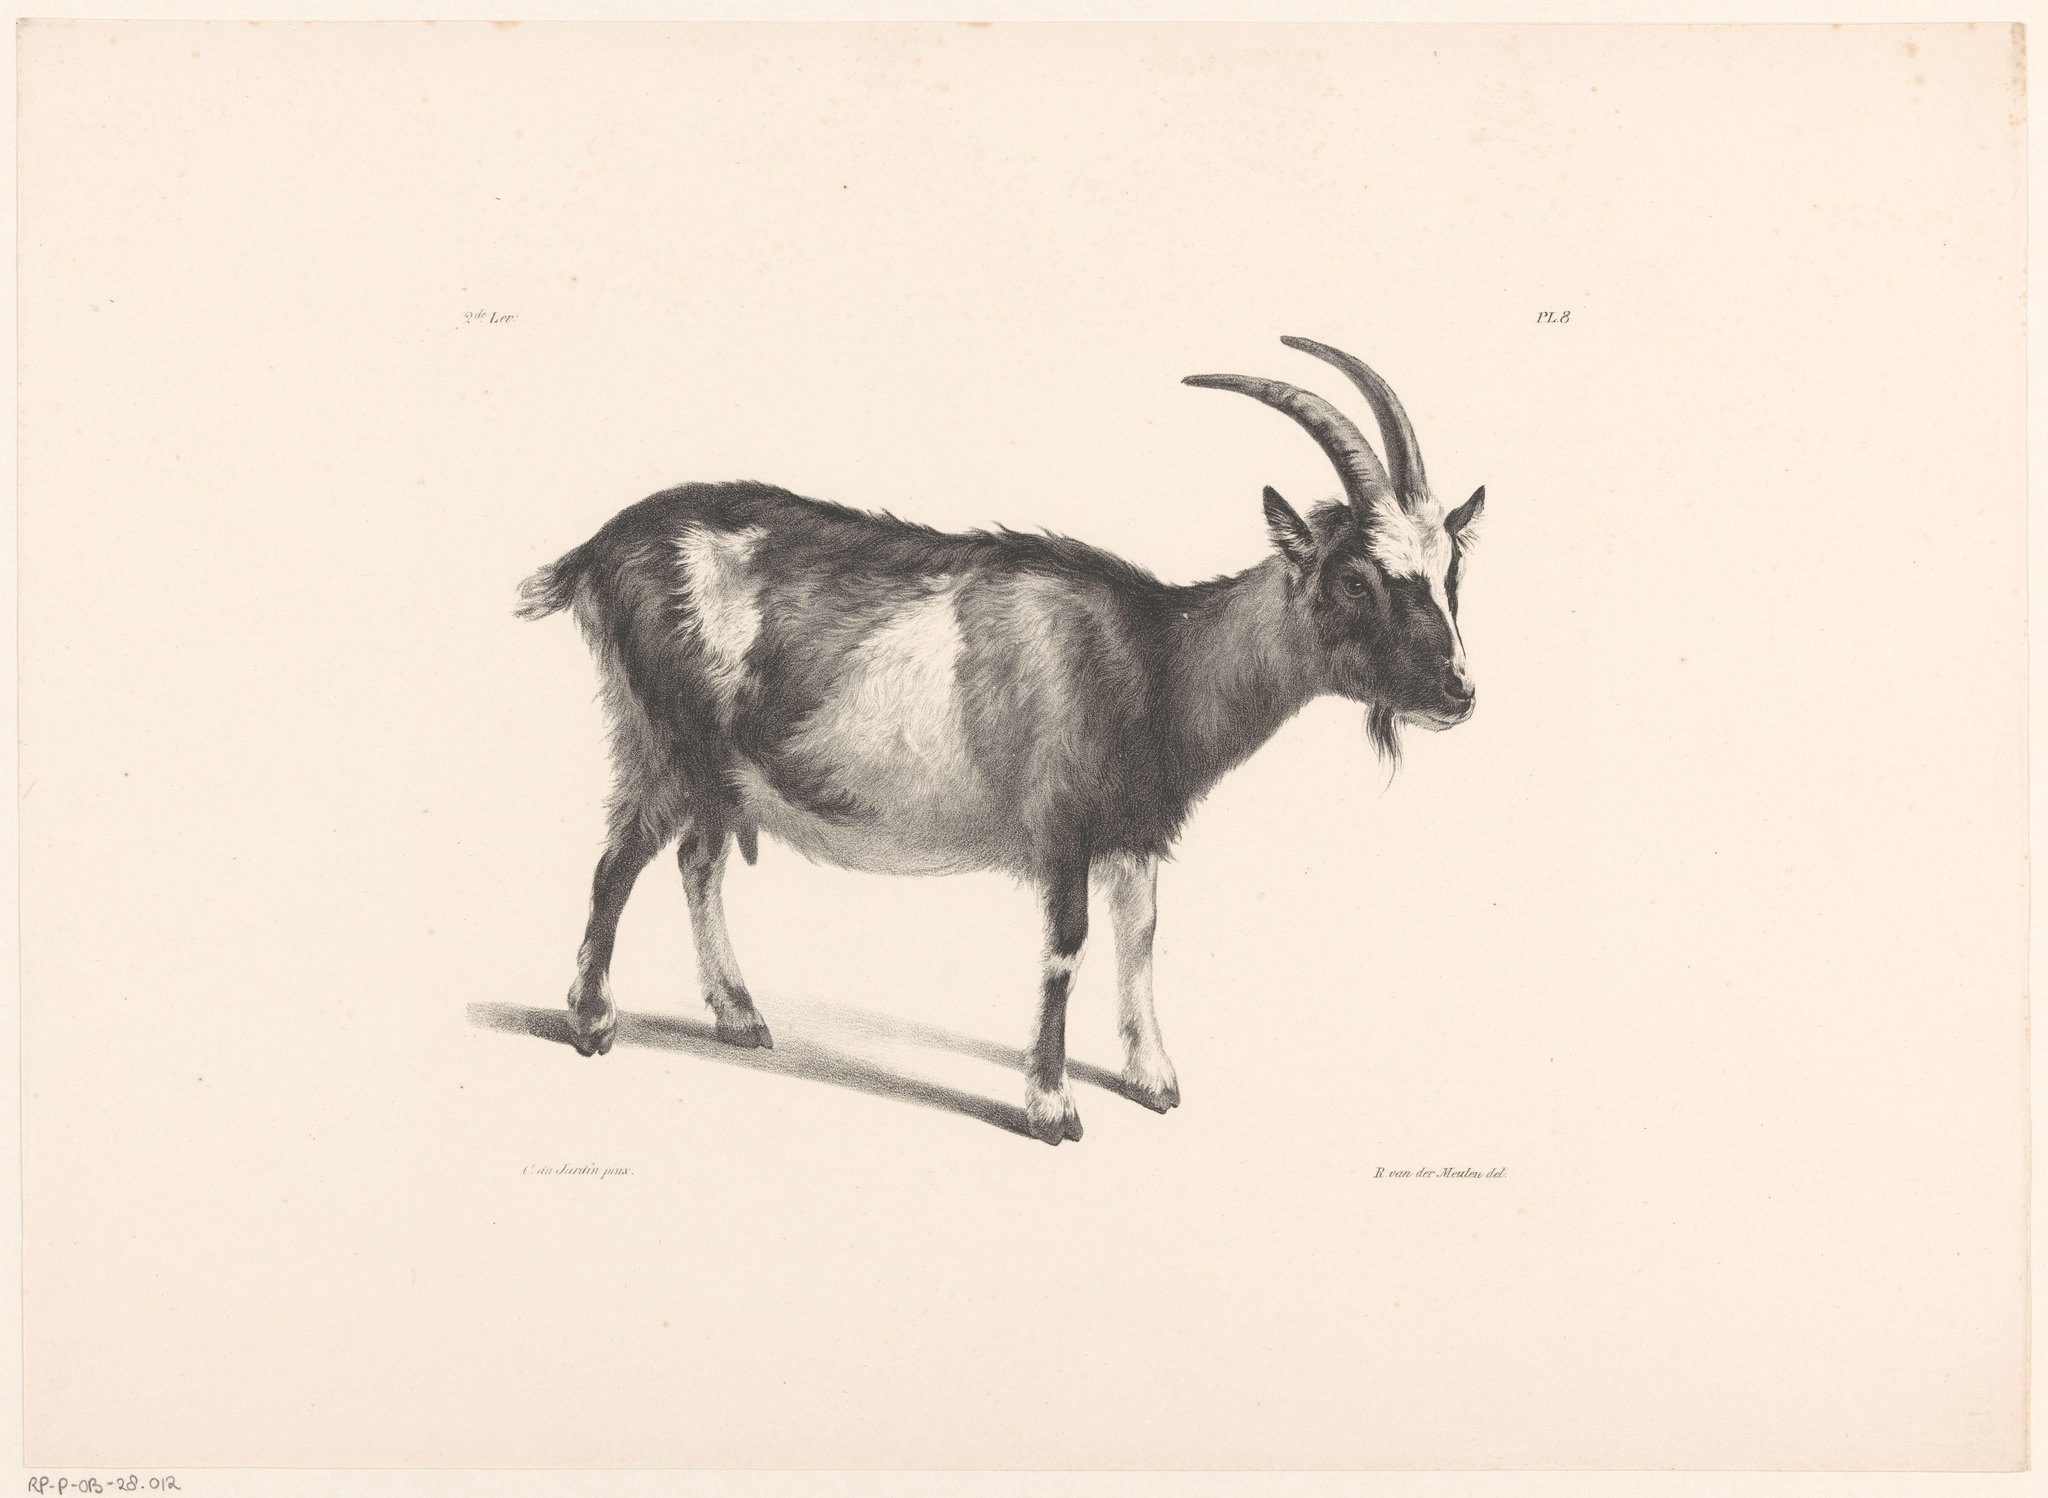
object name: print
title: Geit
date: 1820-1833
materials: paper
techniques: lithograph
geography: amsterdam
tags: she-goat, nanny-goat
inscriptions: collector's mark: Lugt 2228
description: Deze prent maakte mogelijk deel uit van de serie: 'Origineele Beesten Studien op Steen getekend na Potter, Van de Velde, Berghem, en andere Oude Hollandsche Meesters' door J. A. Daiwaille.